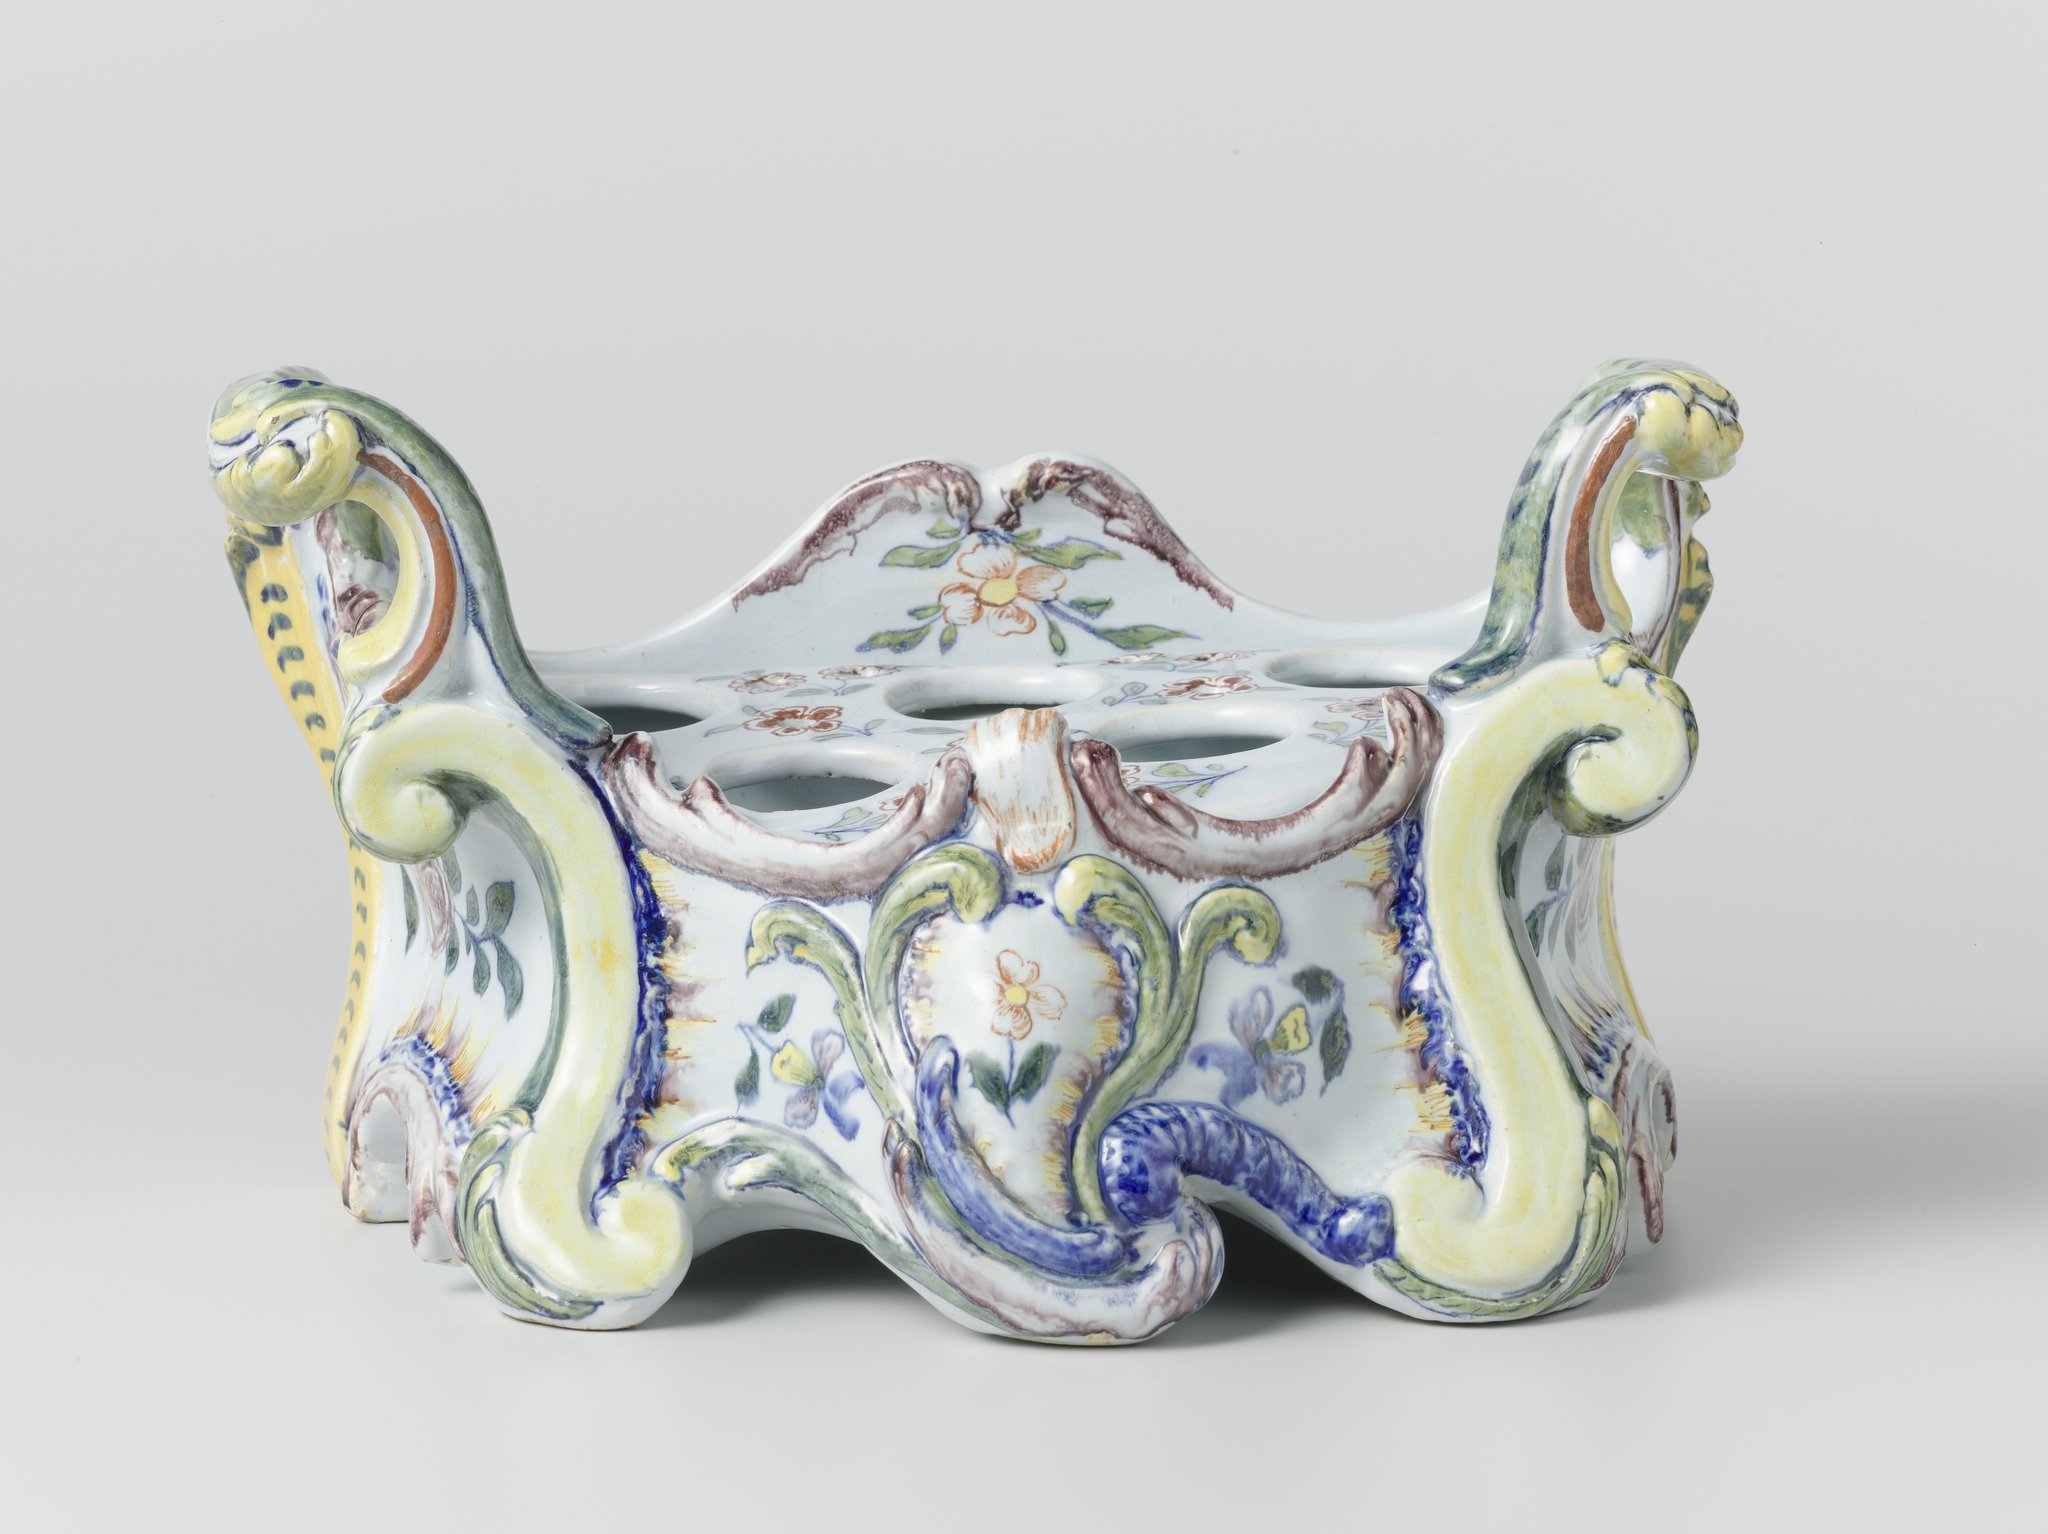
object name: bloemhouder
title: Plaat met vijf openingen, behorend bij een bloemhouder veelkleurig beschilderd met strooibloemen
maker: hendrik van hoorn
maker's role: eigenaar plateelbakkerij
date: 1770-1780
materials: faience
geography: delft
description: Plaat met vijf openingen, behorend bij een bloemhouder van faïence. Veelkleurig beschilderd met strooibloemen.